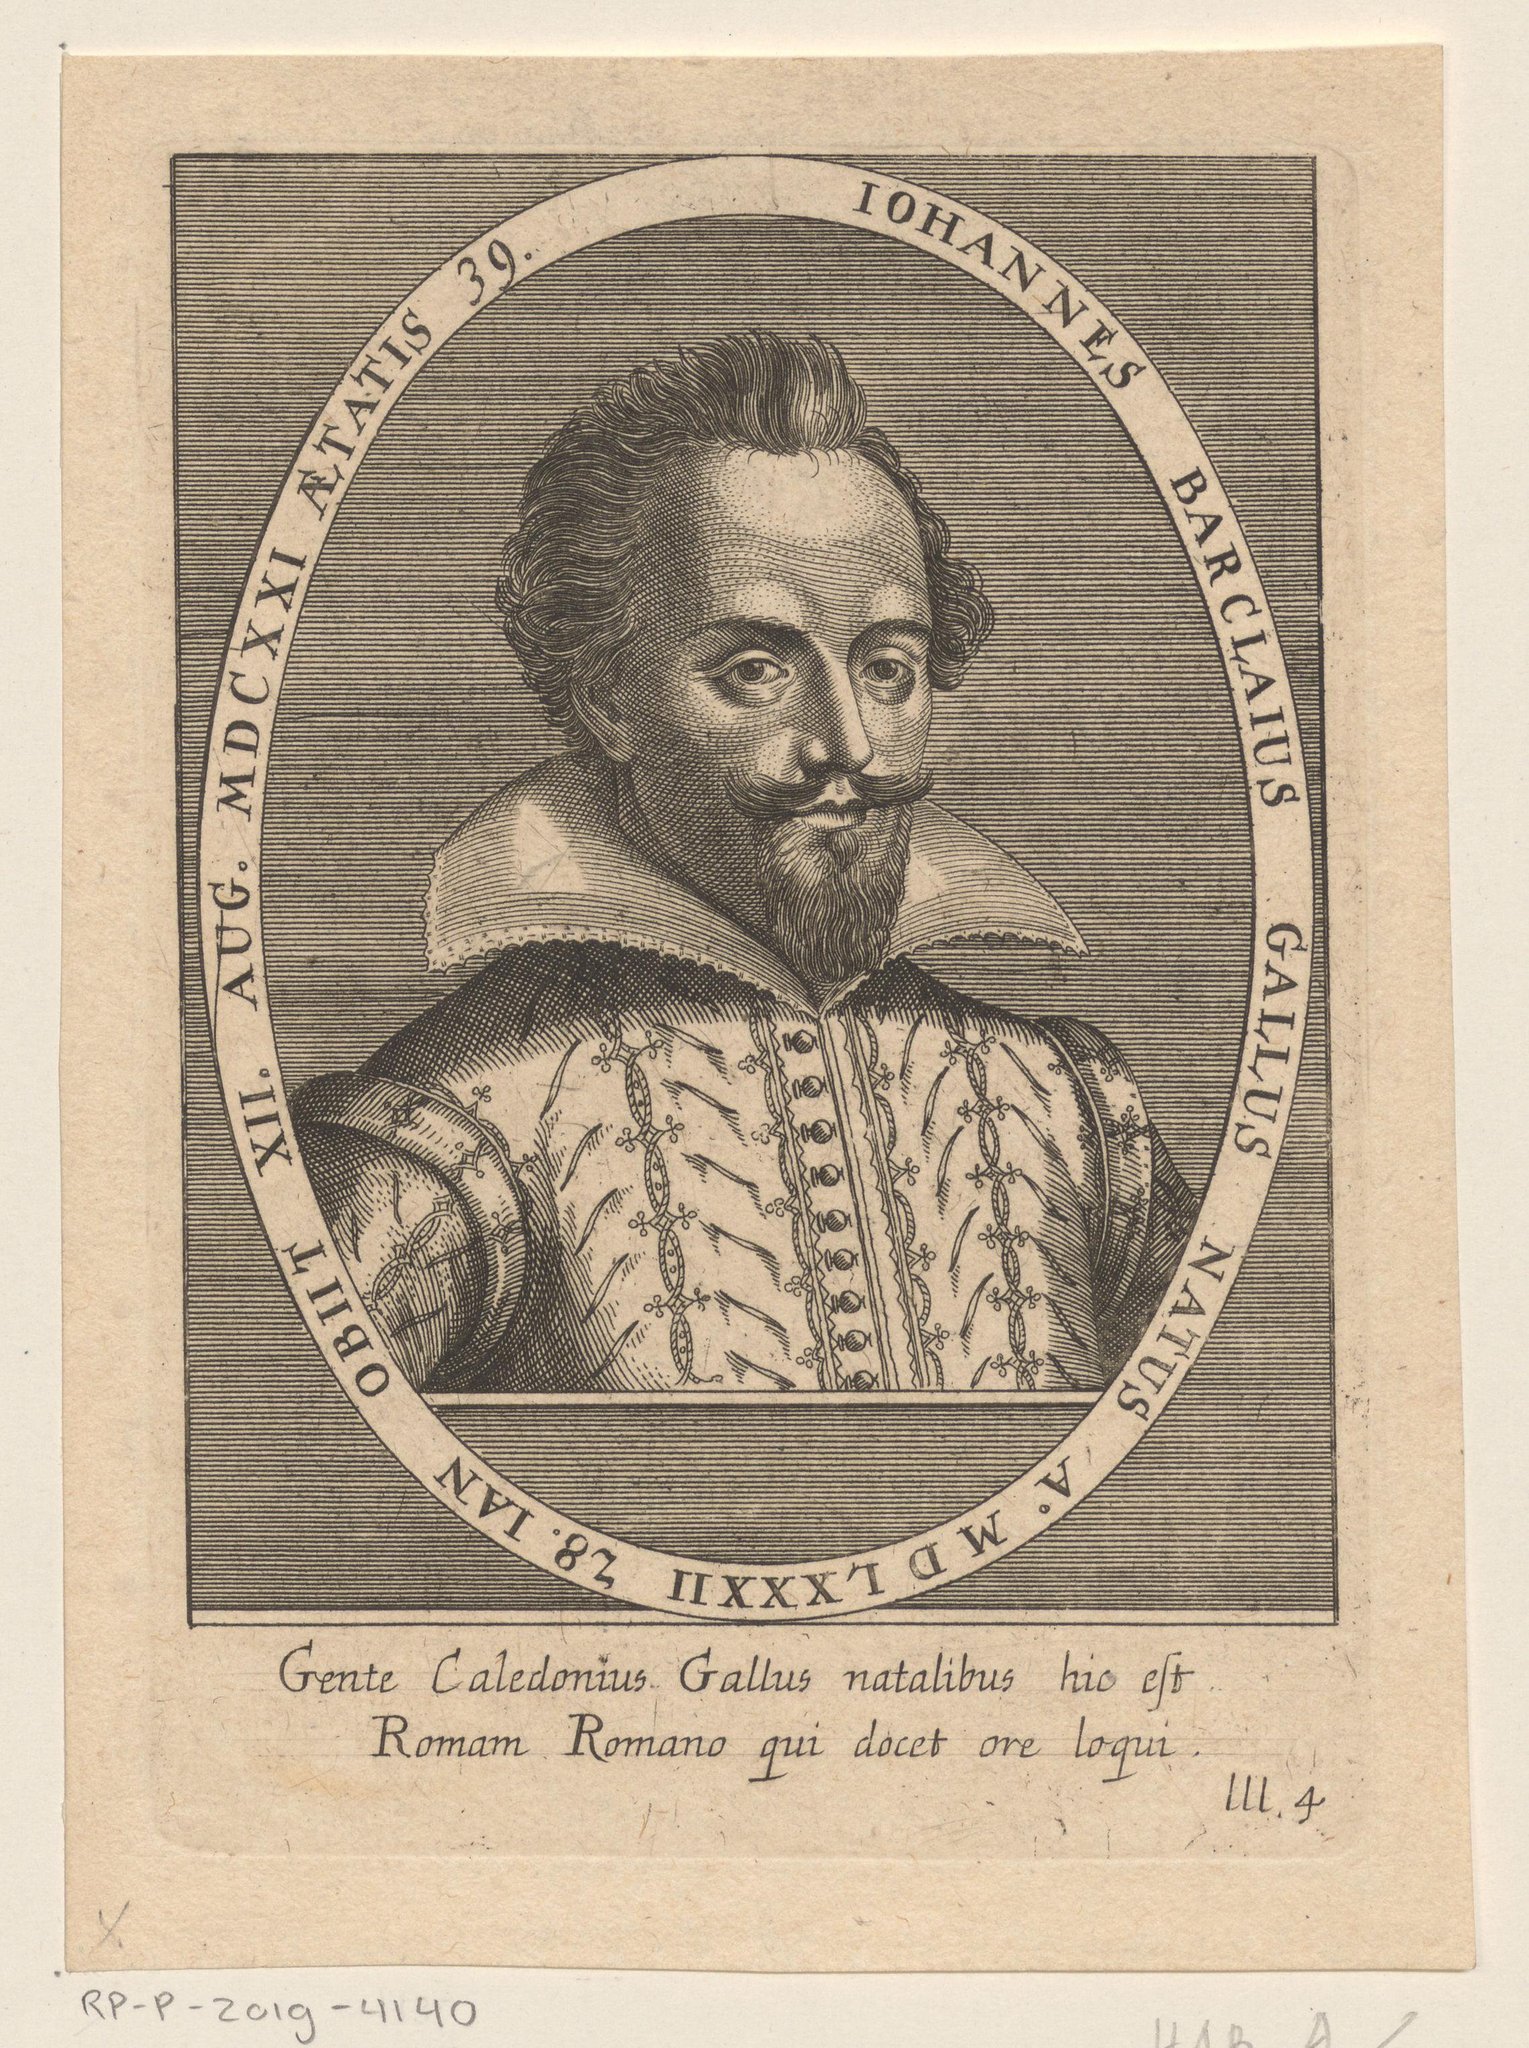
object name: print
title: Portret van John Barclay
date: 1652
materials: paper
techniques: engraving, etching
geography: frankfurt am main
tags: rome, historical persons, portrait of a writer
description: Prent uit: Boissard, Jean Jacques. Bibliotheca chalcographica. Frankfurt am Main: Johannes Ammon, 1652, dl. 8.